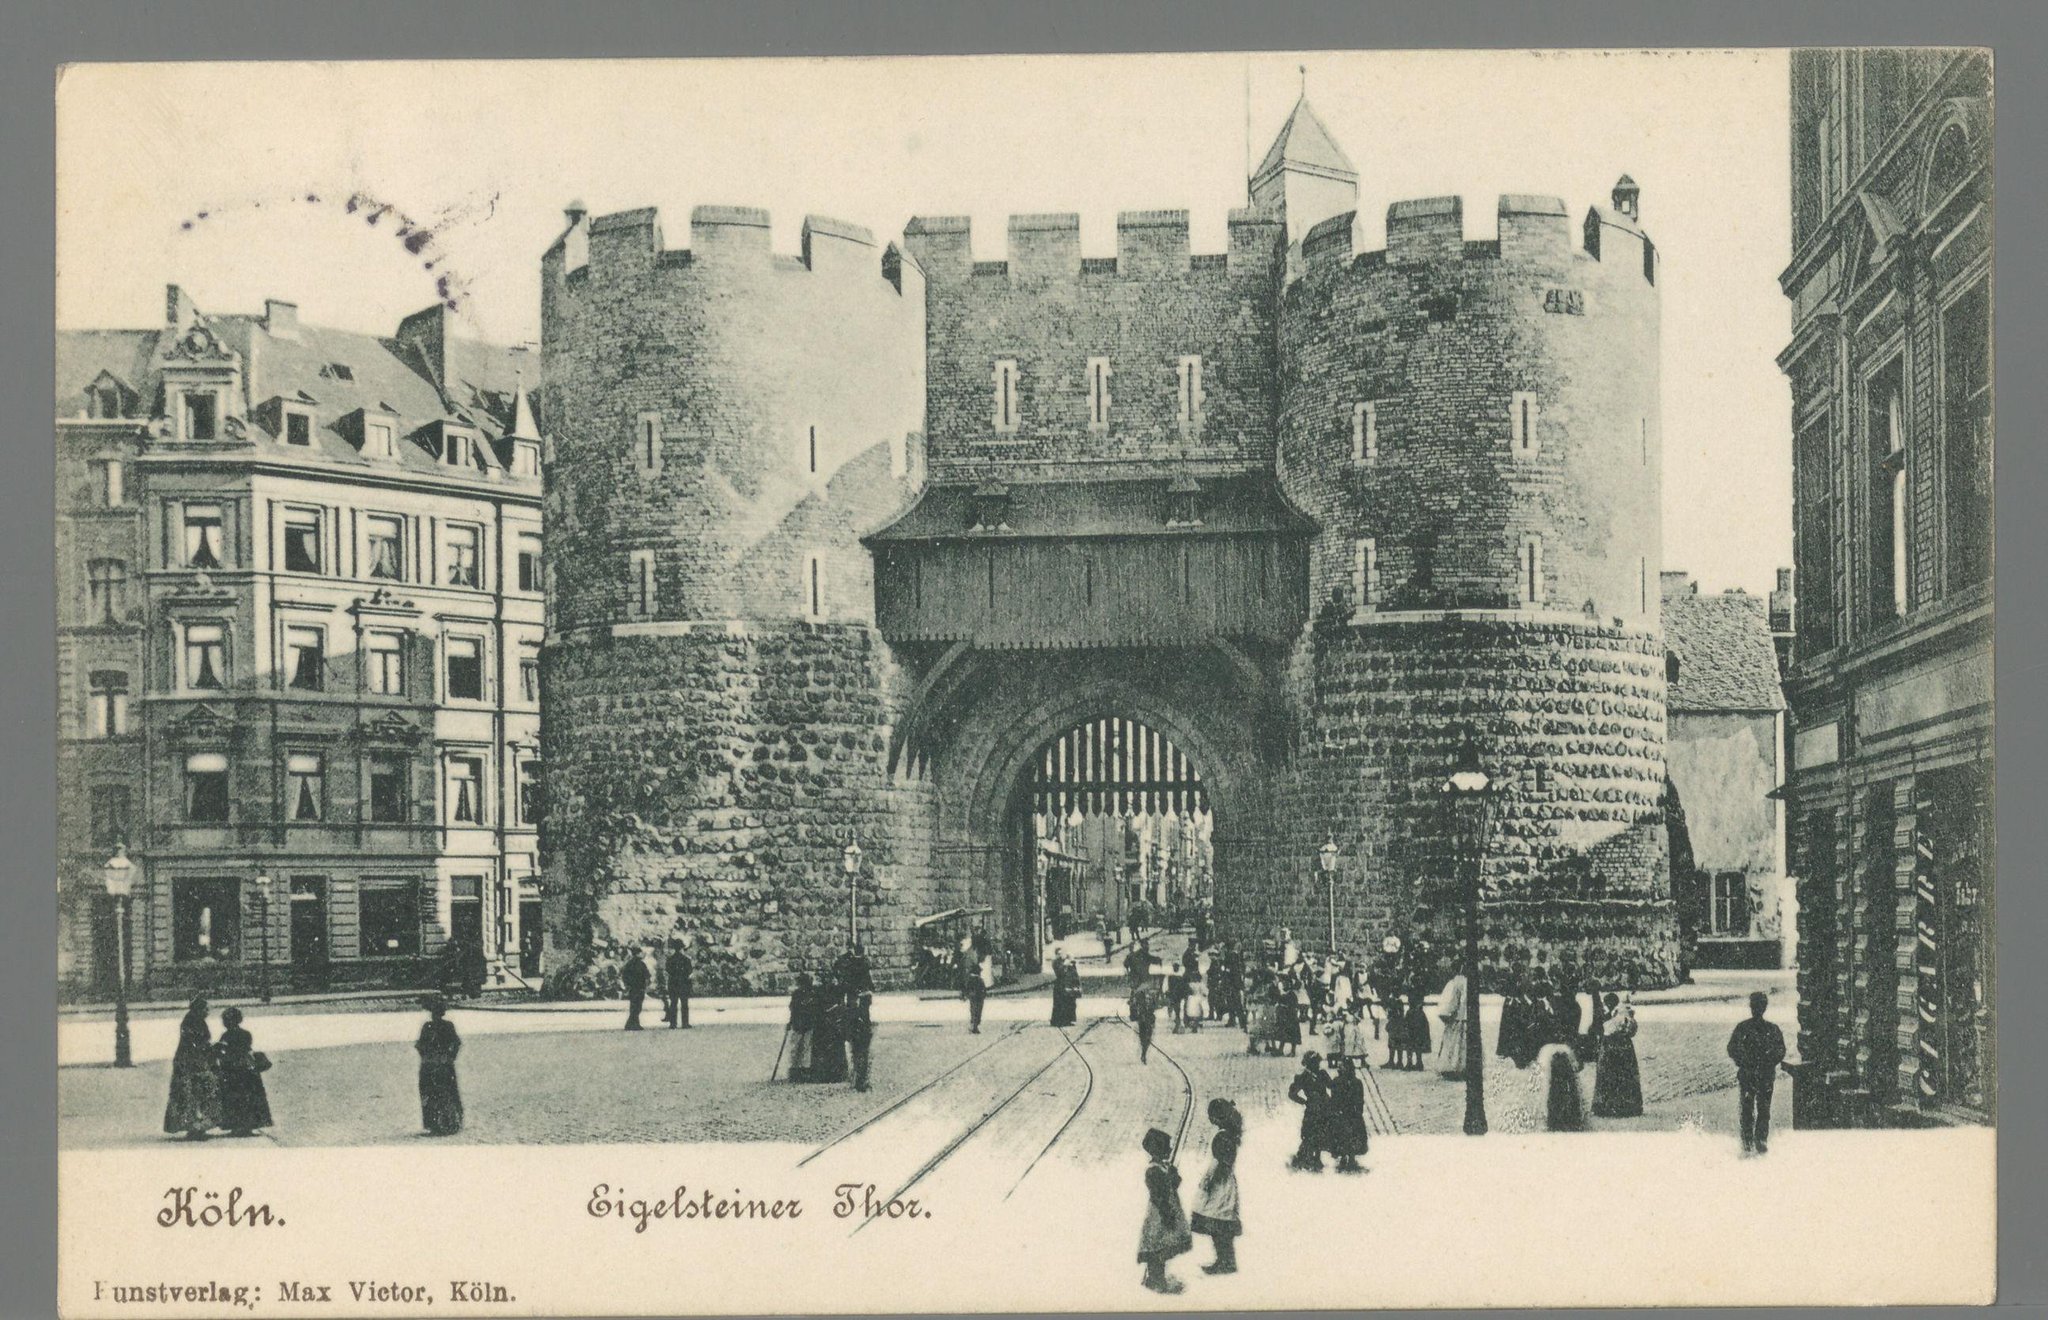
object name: ansichtkaart, prentbriefkaart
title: Köln. Eigelsteiner Thor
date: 1885-1902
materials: cardboard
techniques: photograph, writing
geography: cologne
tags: castle, city-gate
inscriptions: postage stamp